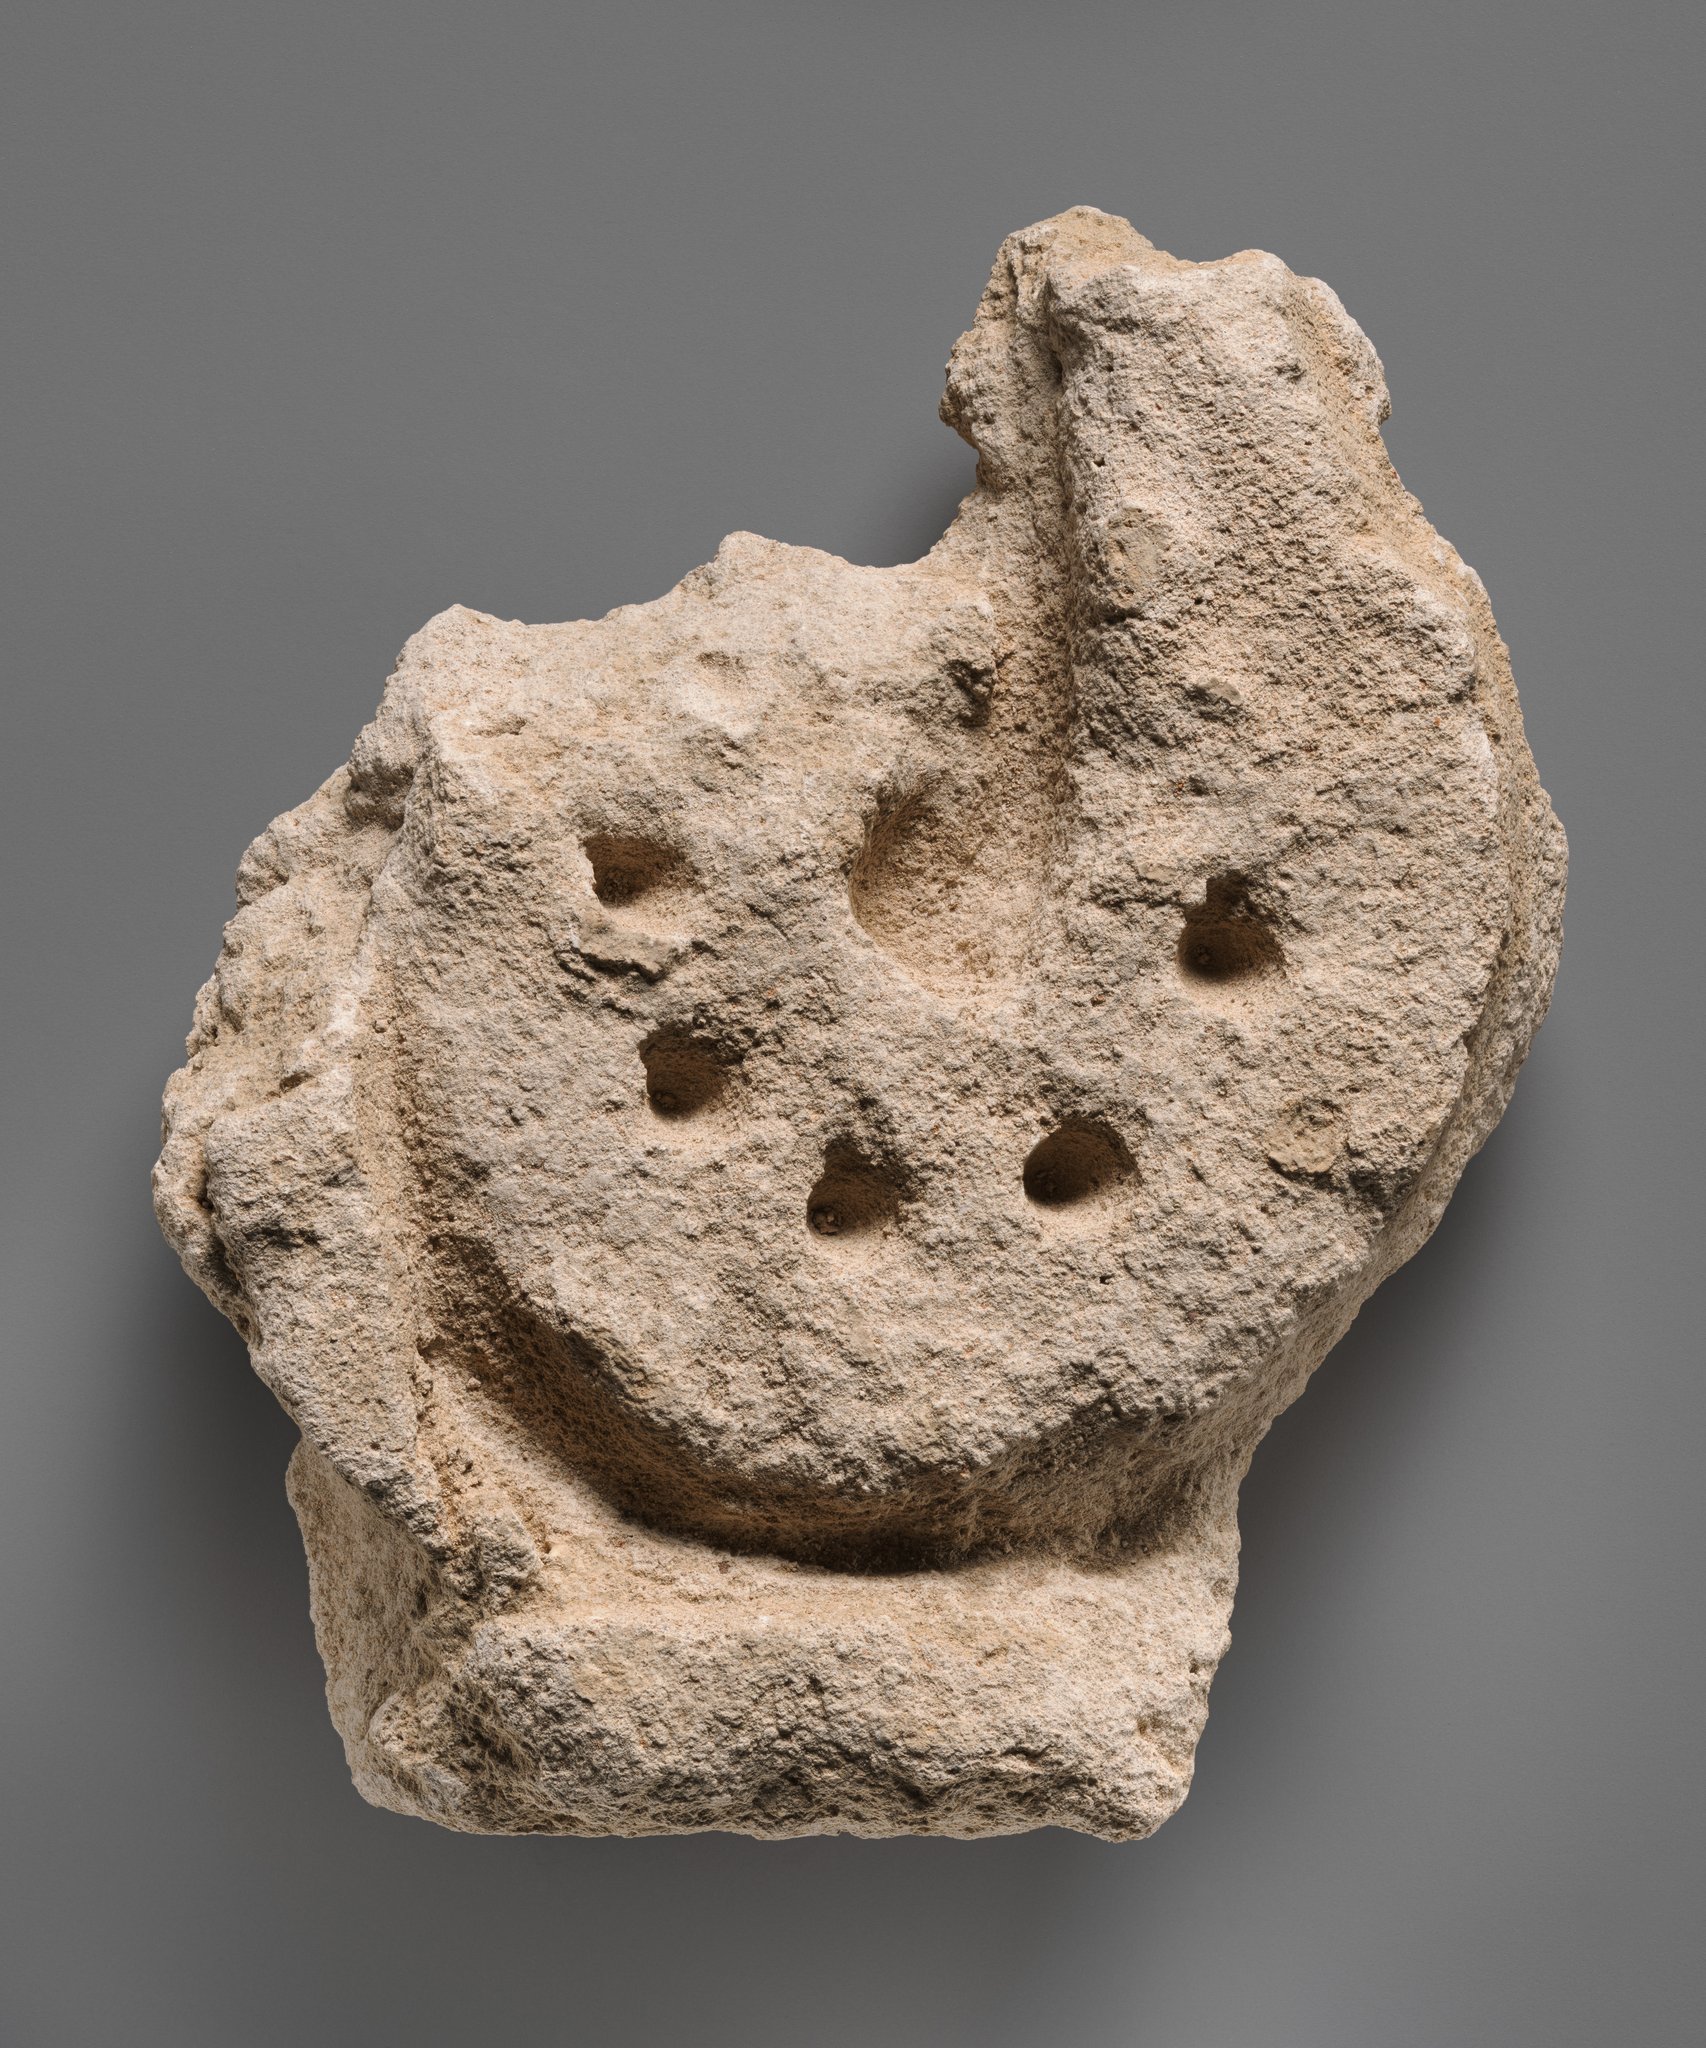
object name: relief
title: Relief fragment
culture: sasanian or islamic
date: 501-800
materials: plaster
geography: mesopotamia